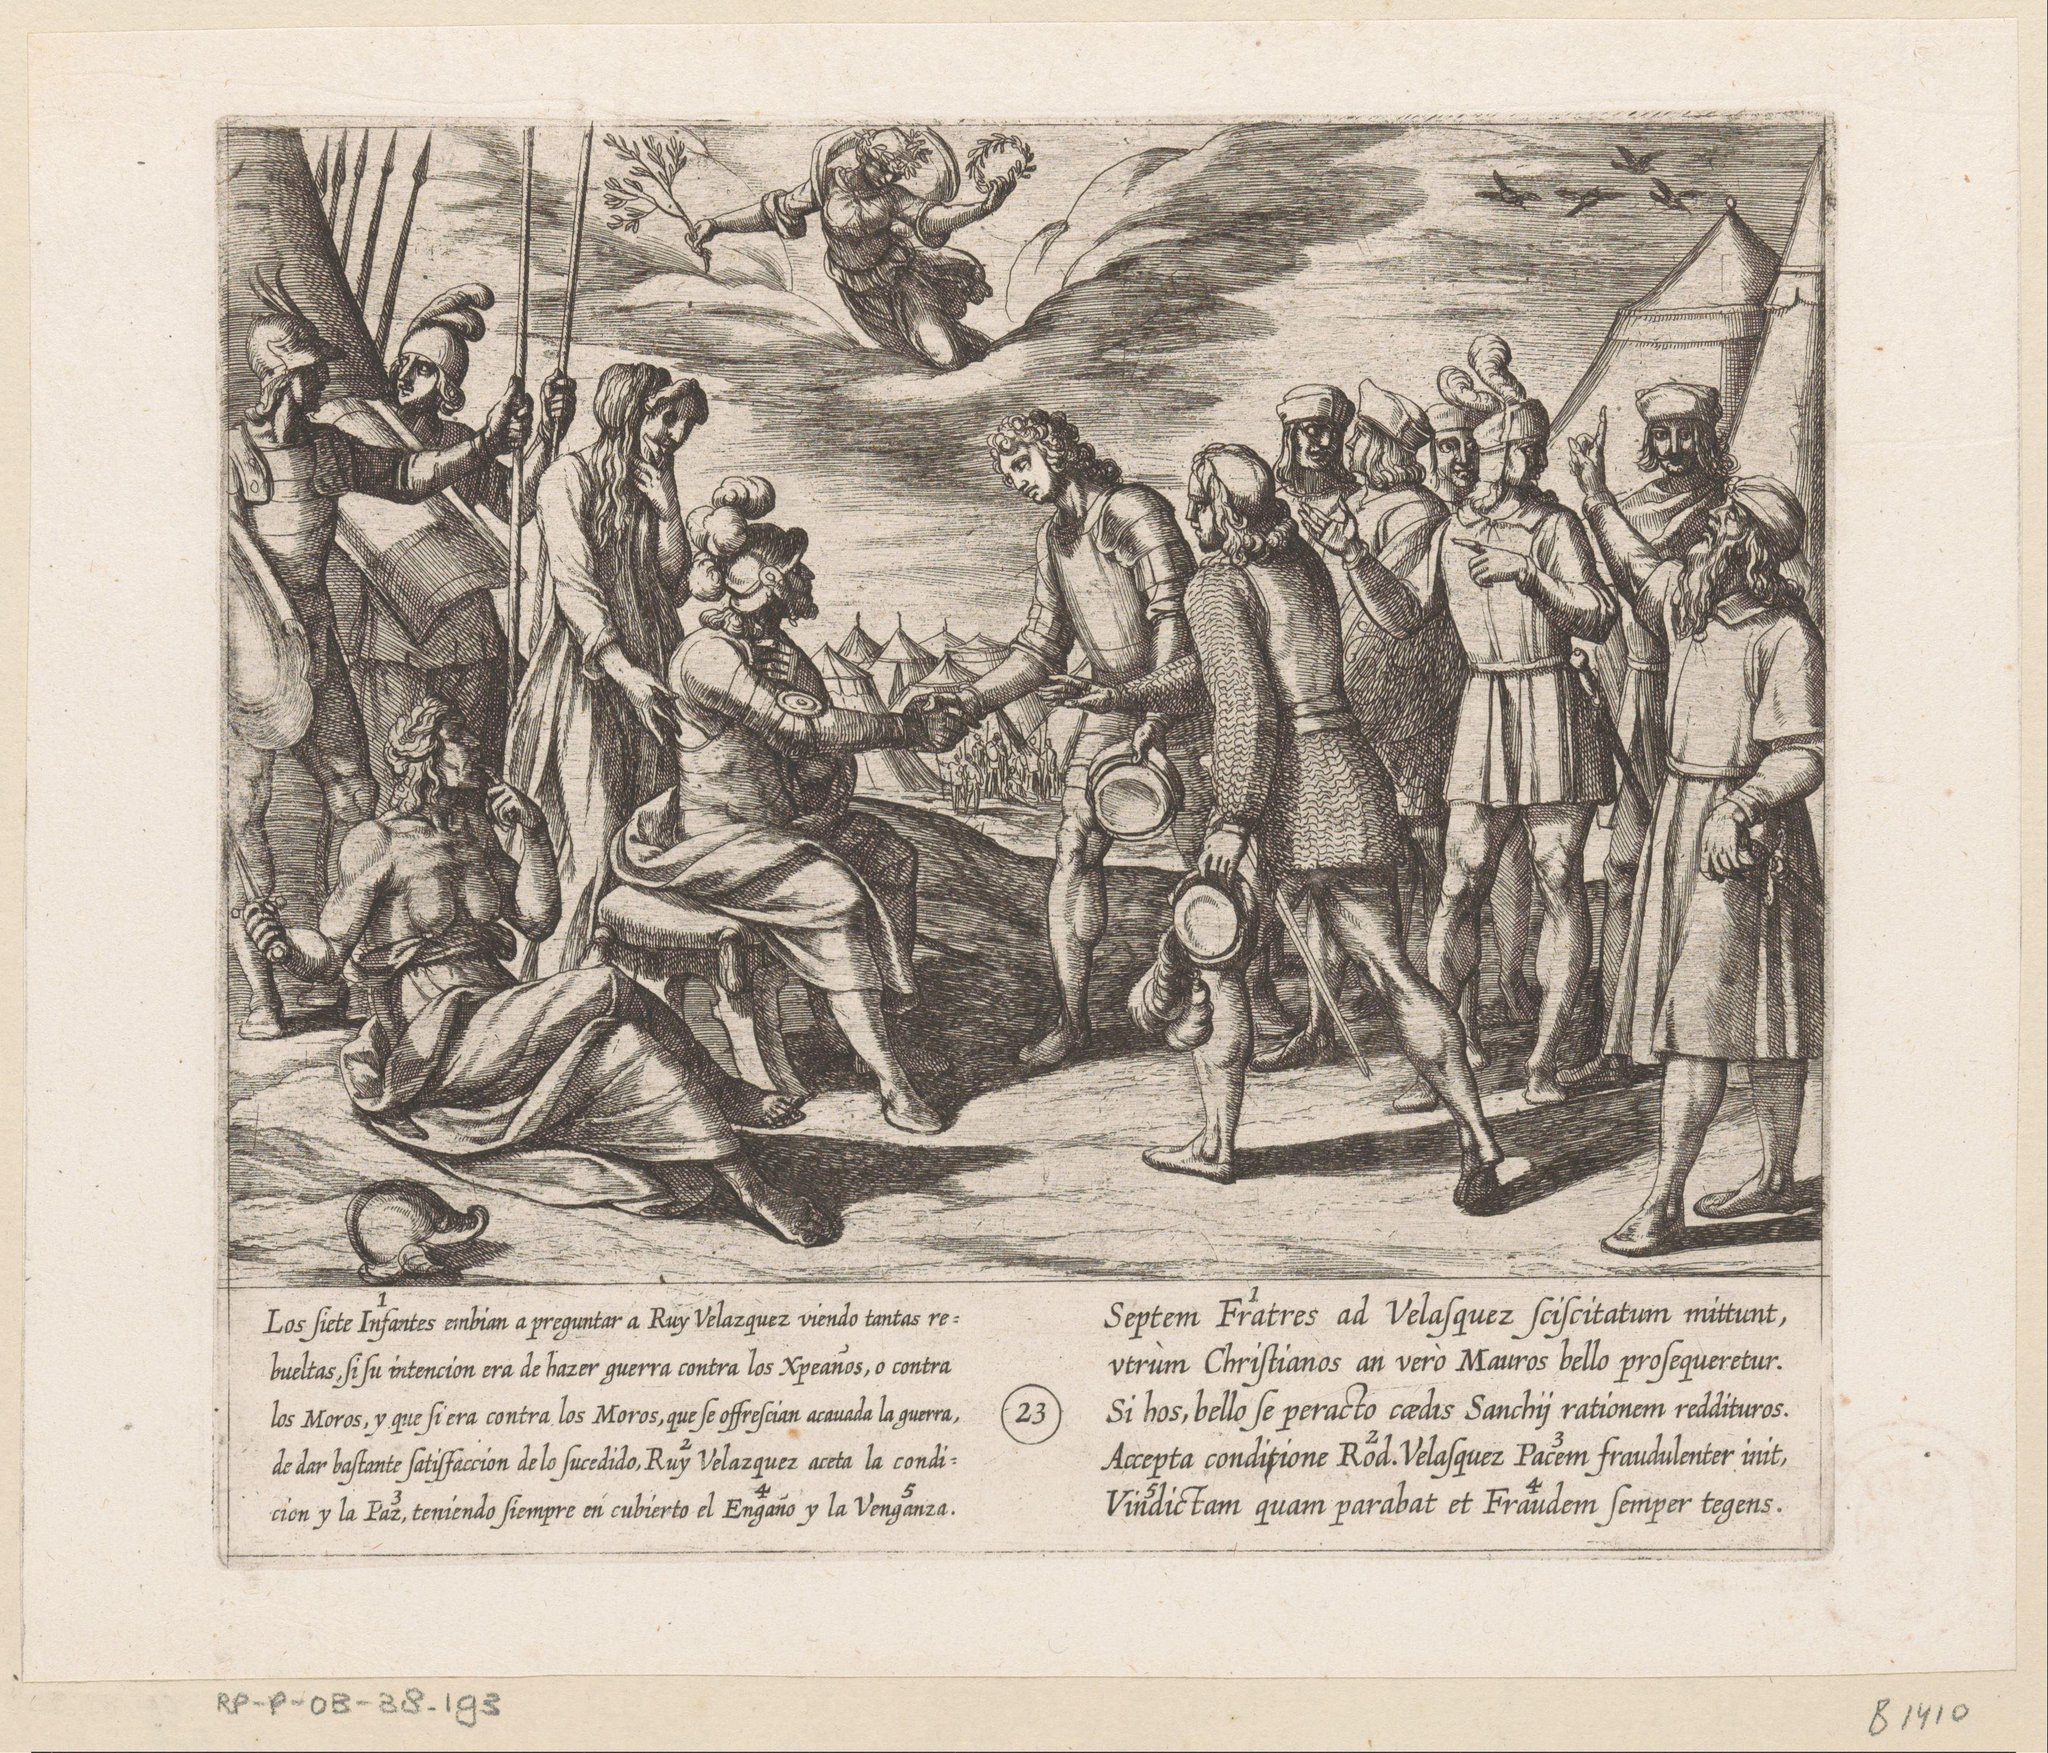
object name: print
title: De zeven infanten van Lara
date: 1612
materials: paper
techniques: etching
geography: italy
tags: (military) camp with tents, peace negotiations, tales and fairy tales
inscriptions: collector's mark: Lugt 240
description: Deze prent maakt deel uit van een reeks van 40 prenten (+ titelprent) met voorstellingen uit het volksverhaal over de zeven infanten van Lara.